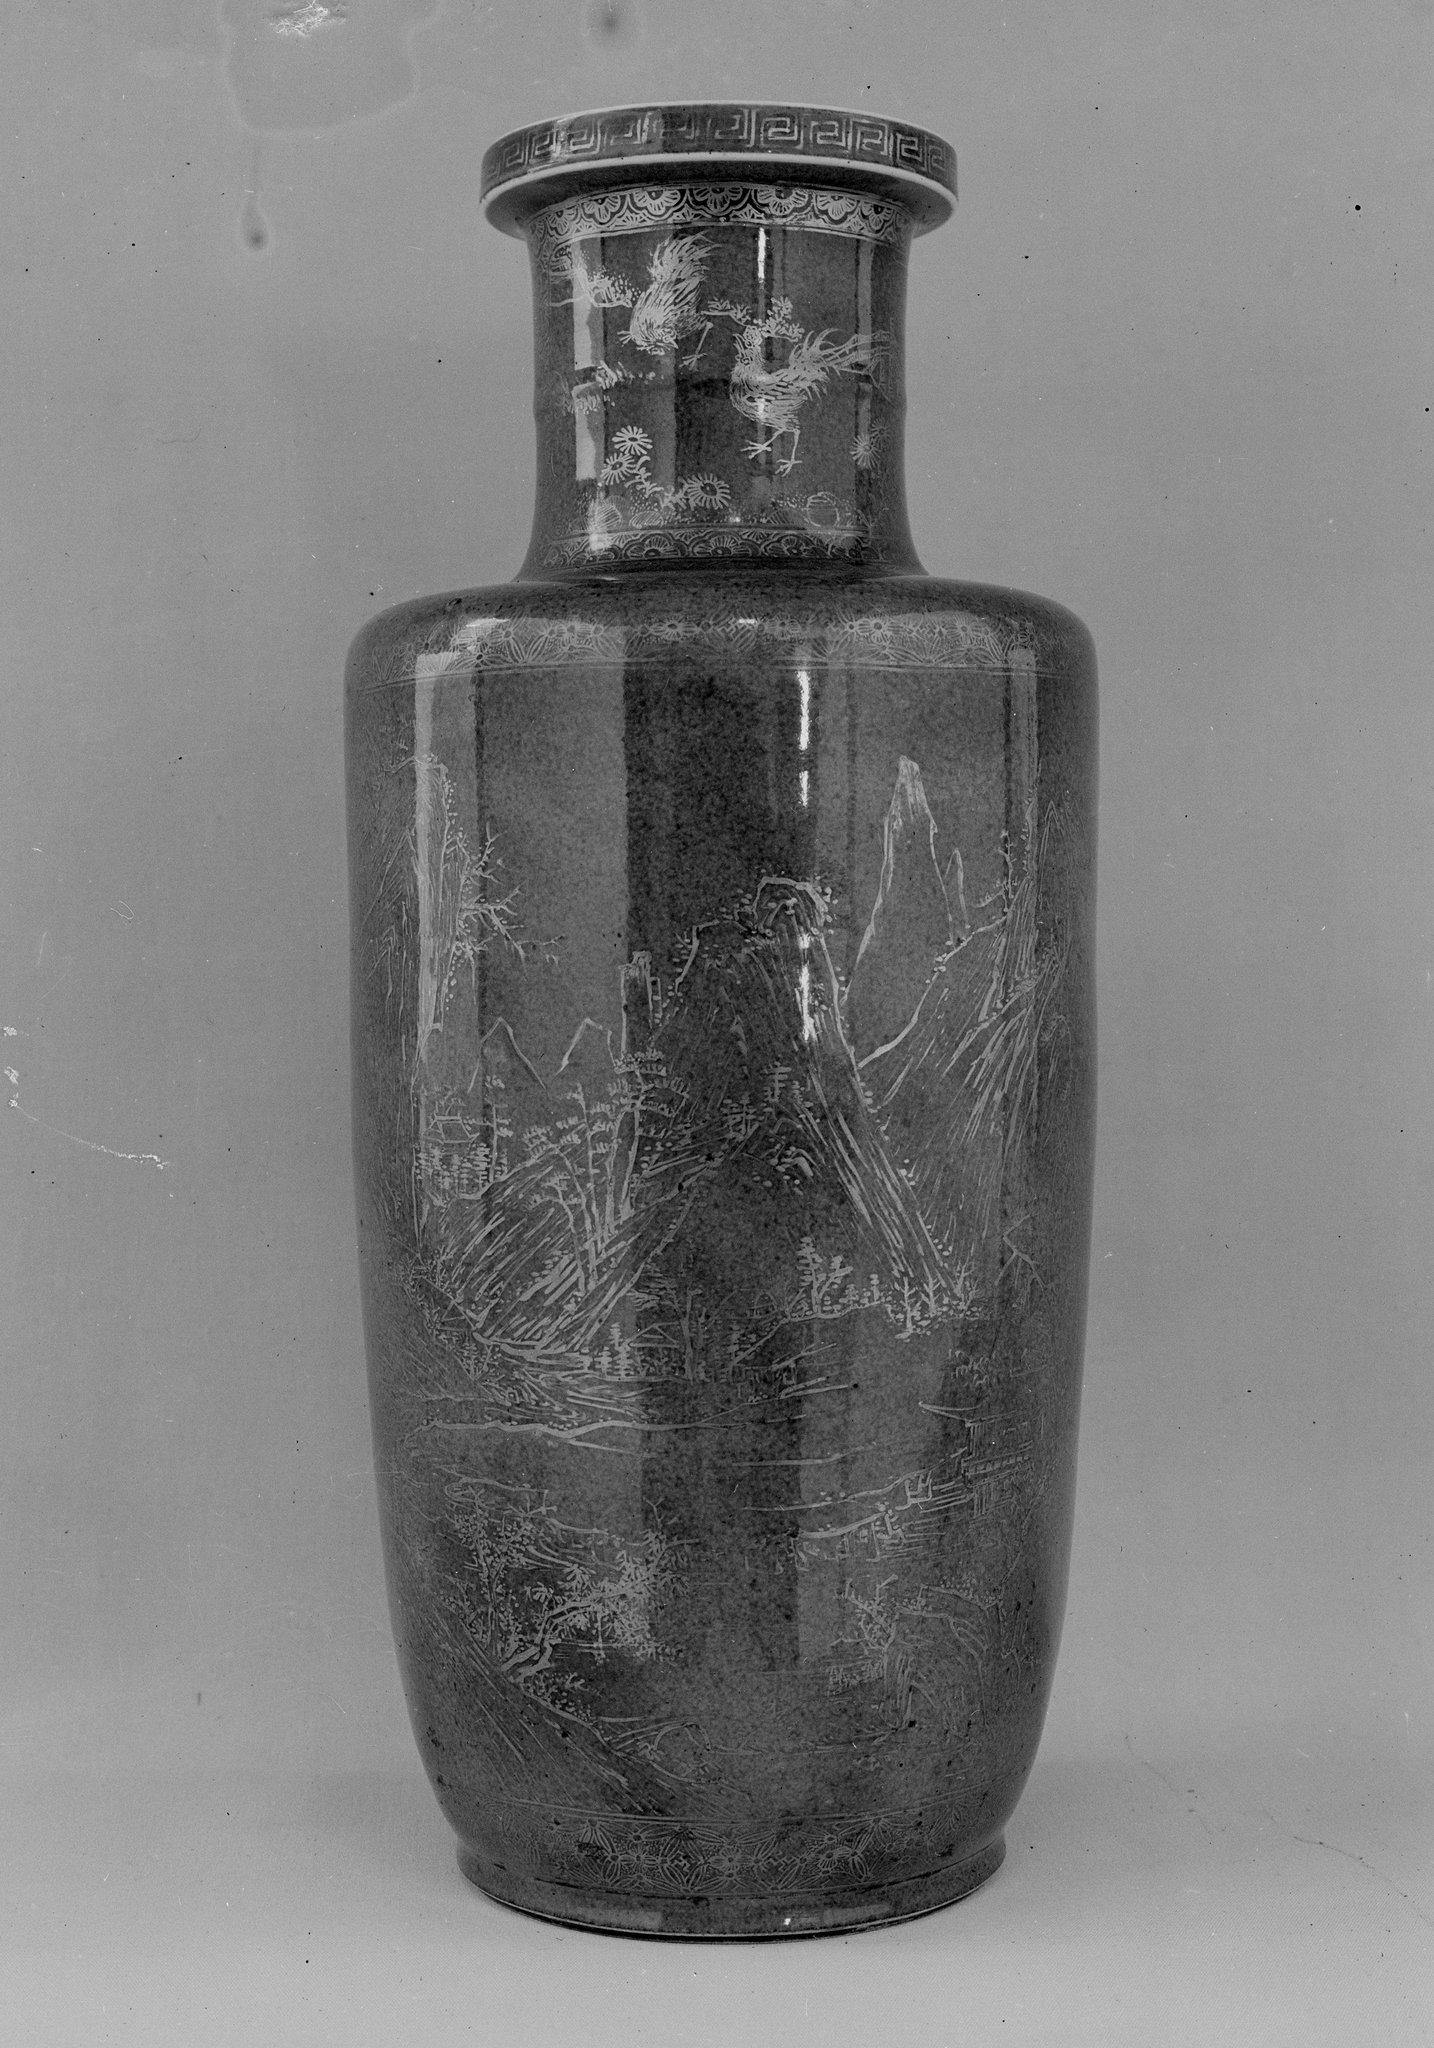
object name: vase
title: Vase with landscape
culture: chinese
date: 1662-1722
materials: glaze, gold, porcelain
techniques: painting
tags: landscapes